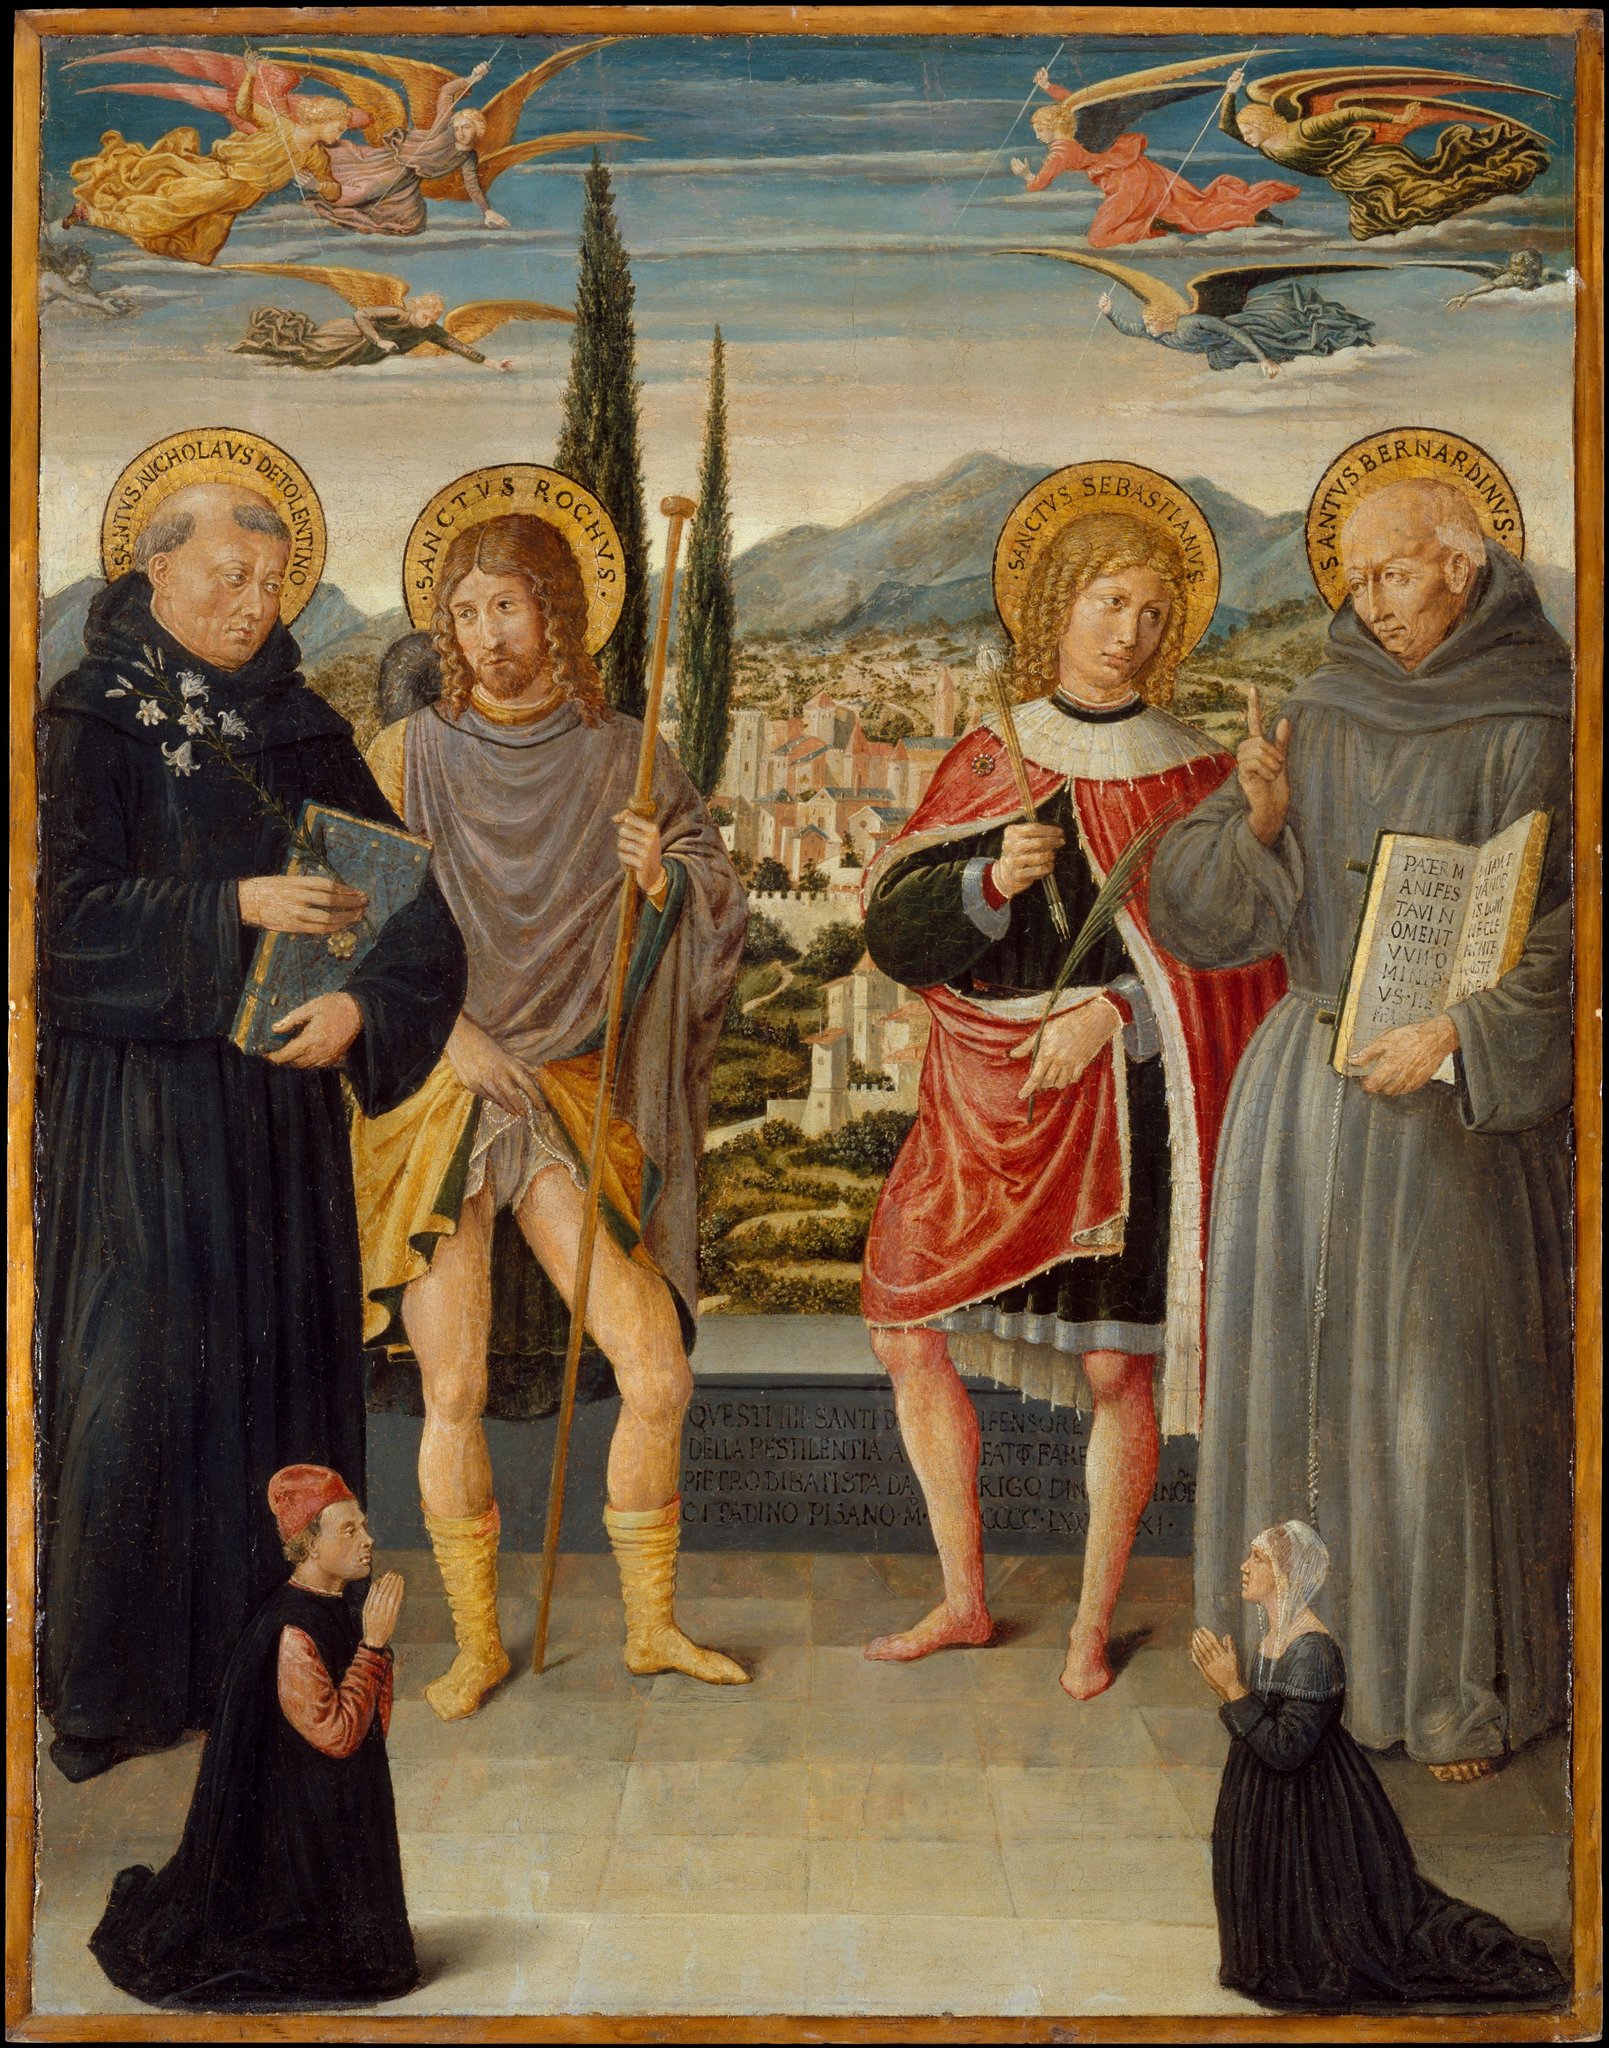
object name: painting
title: Saints Nicholas of Tolentino, Roch, Sebastian, and Bernardino of Siena, with Kneeling Donors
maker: benozzo gozzoli (benozzo di lese di sandro)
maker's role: artist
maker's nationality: italian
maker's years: 1420-1497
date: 1481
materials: canvas, gold, paint, wood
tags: towns,men,women,angels,saints